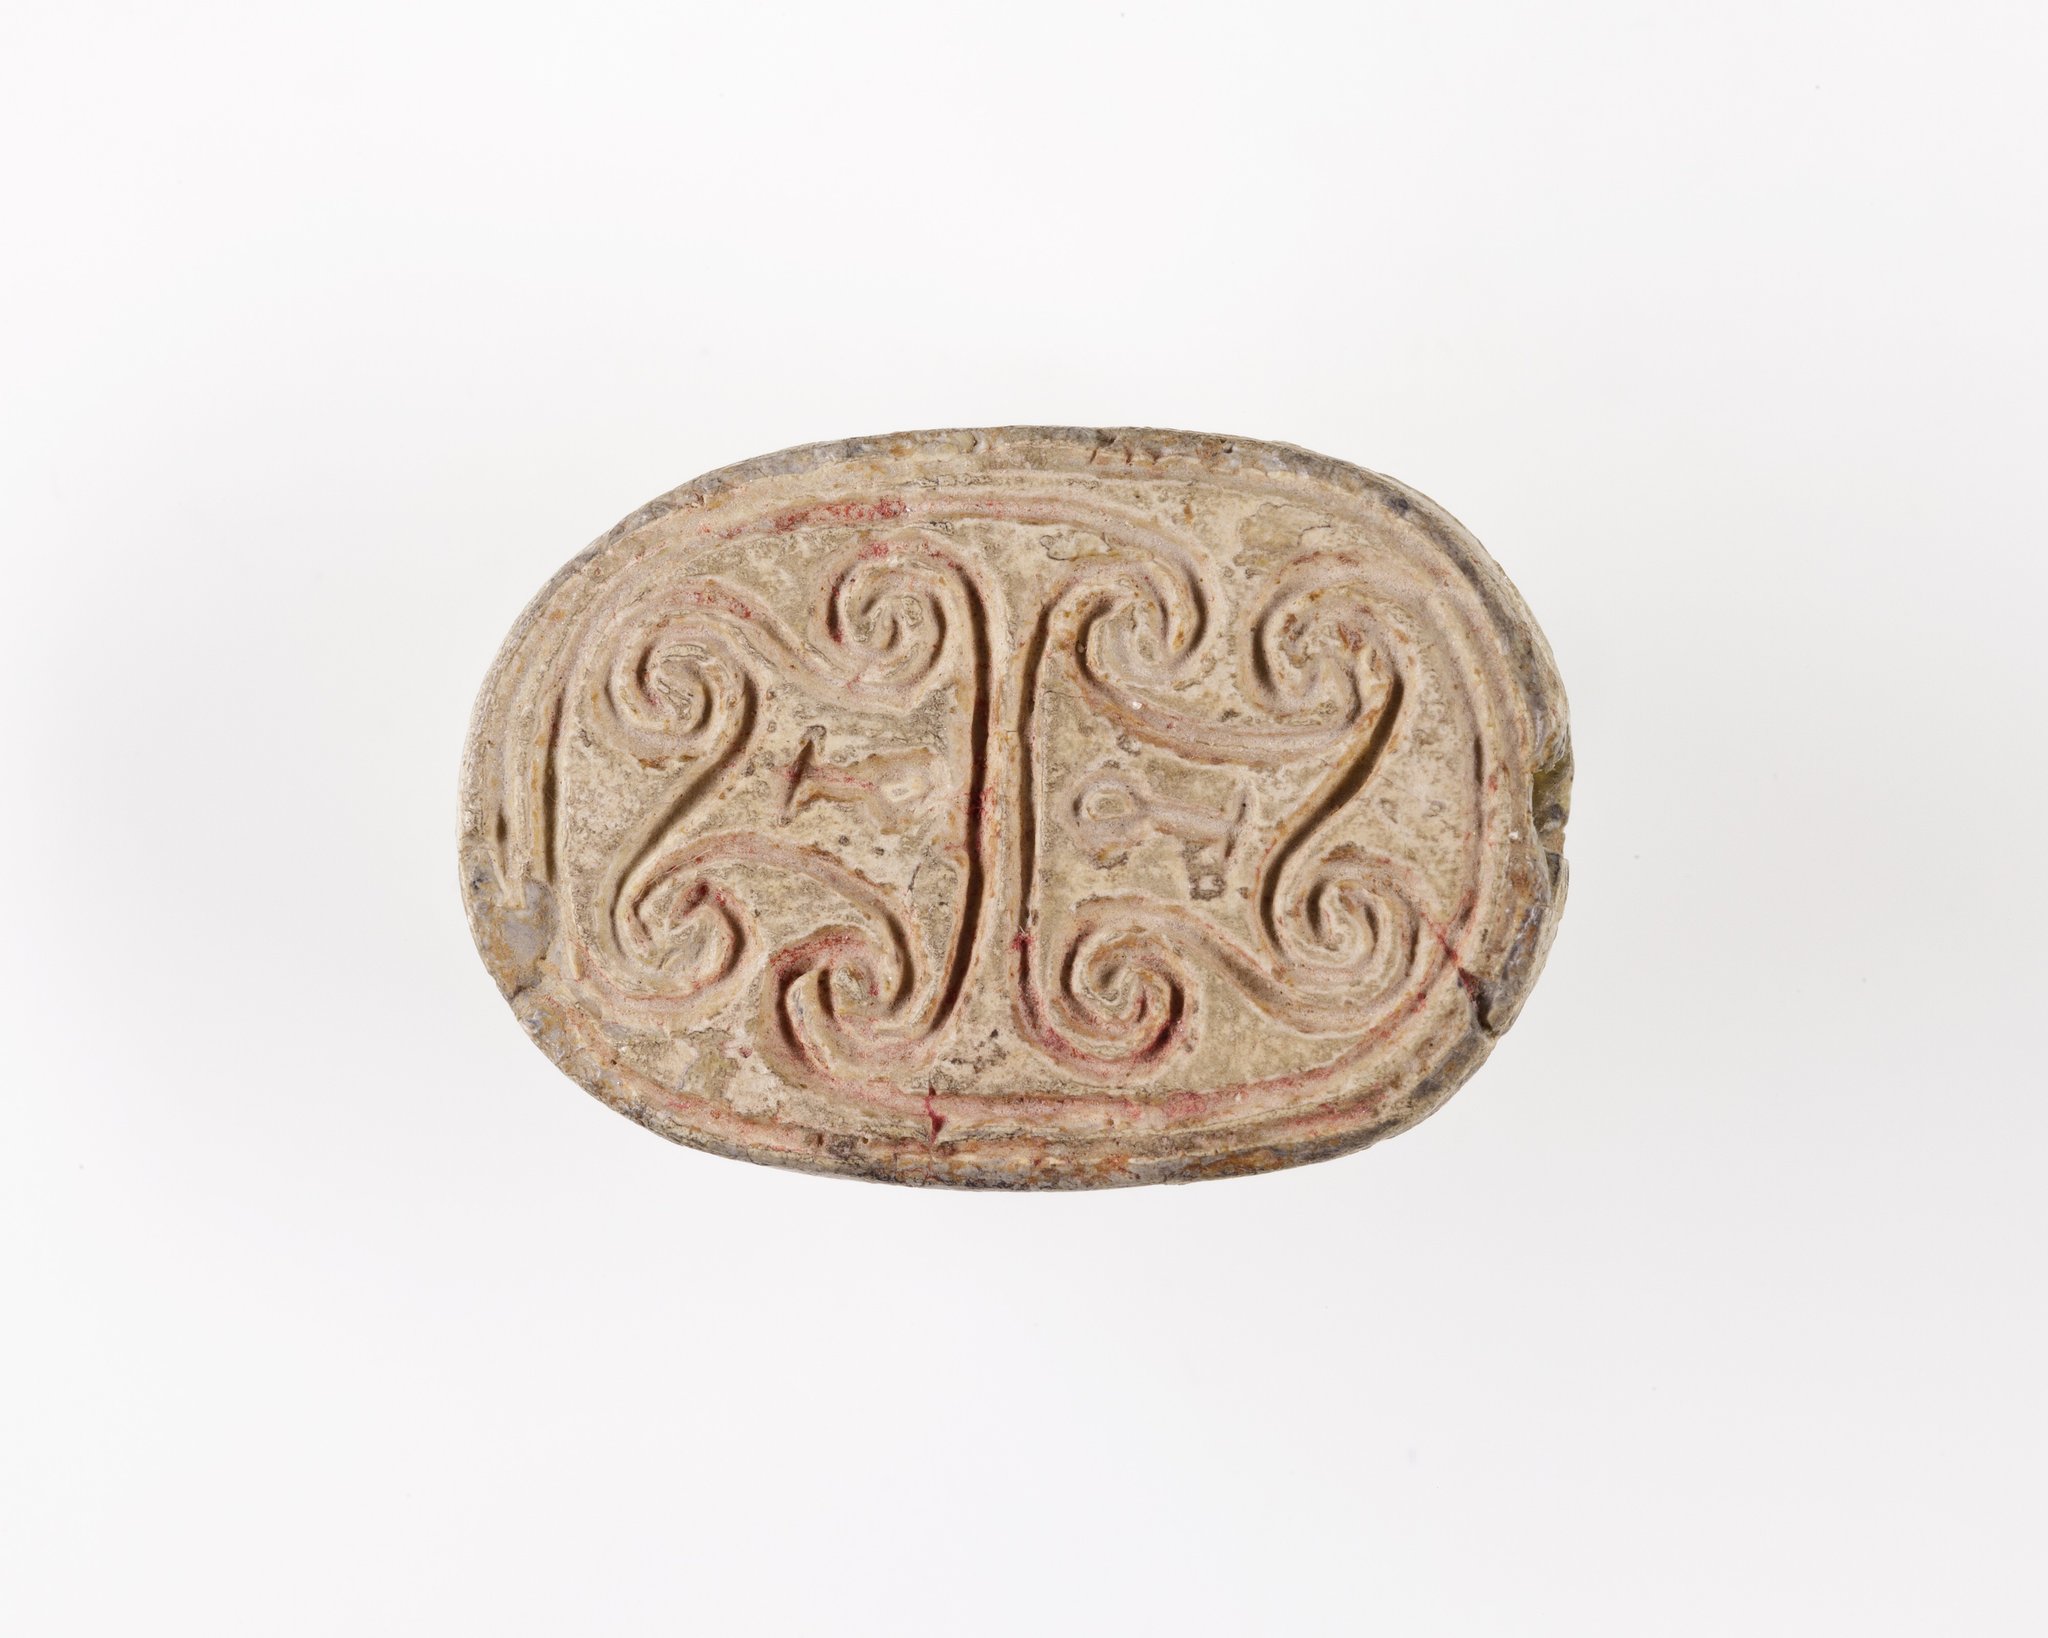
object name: scarab, nefer, scroll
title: Scarab Incised with Hieroglyphs and Scrolls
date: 1760-1670 BCE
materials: stone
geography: egypt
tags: scarabs